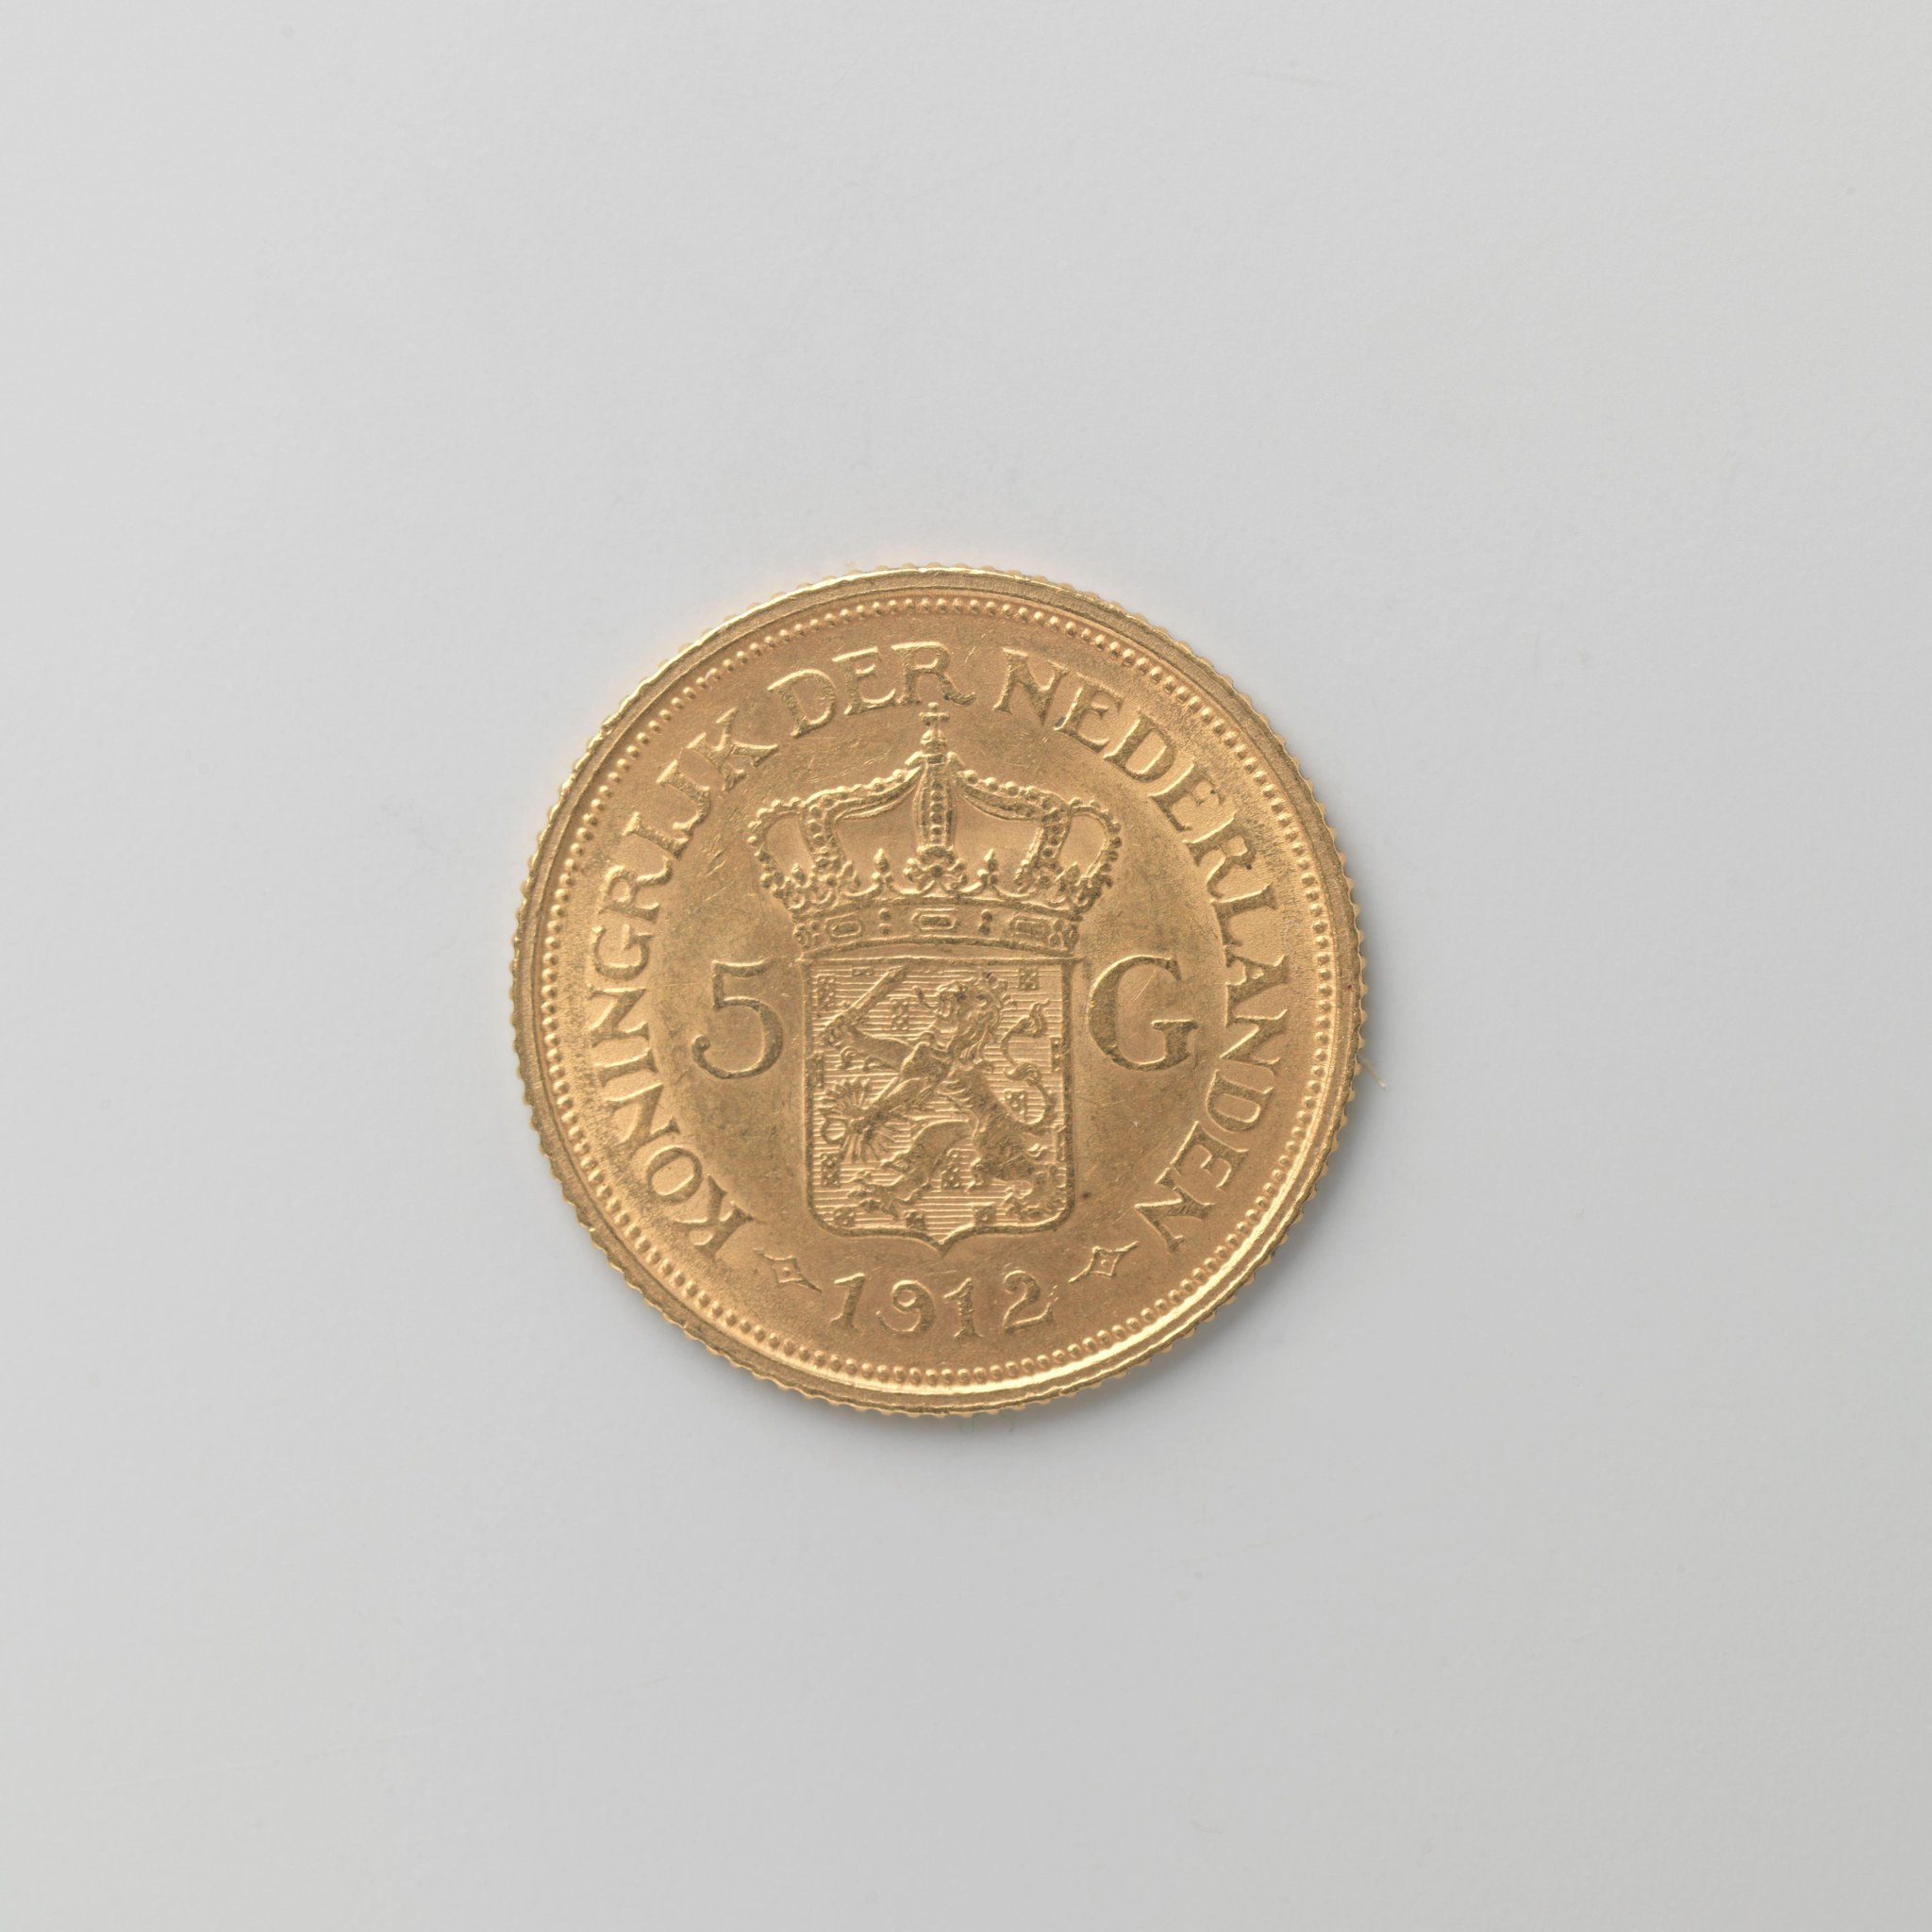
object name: vijf gulden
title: Nederlandse 5 gulden,1912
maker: wilhelmina of the netherlands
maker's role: print maker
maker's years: 1880-1962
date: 1912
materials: gold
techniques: striking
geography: utrecht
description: Gouden munt. Voorzijde: gedrapeerd borstbeeld met diadeem naar rechts. Keerzijde: tussen waarde-aanduiding 5 G gekroond rijkswapenschild. Jaartal onderaan in omschrift. Kartelrand.